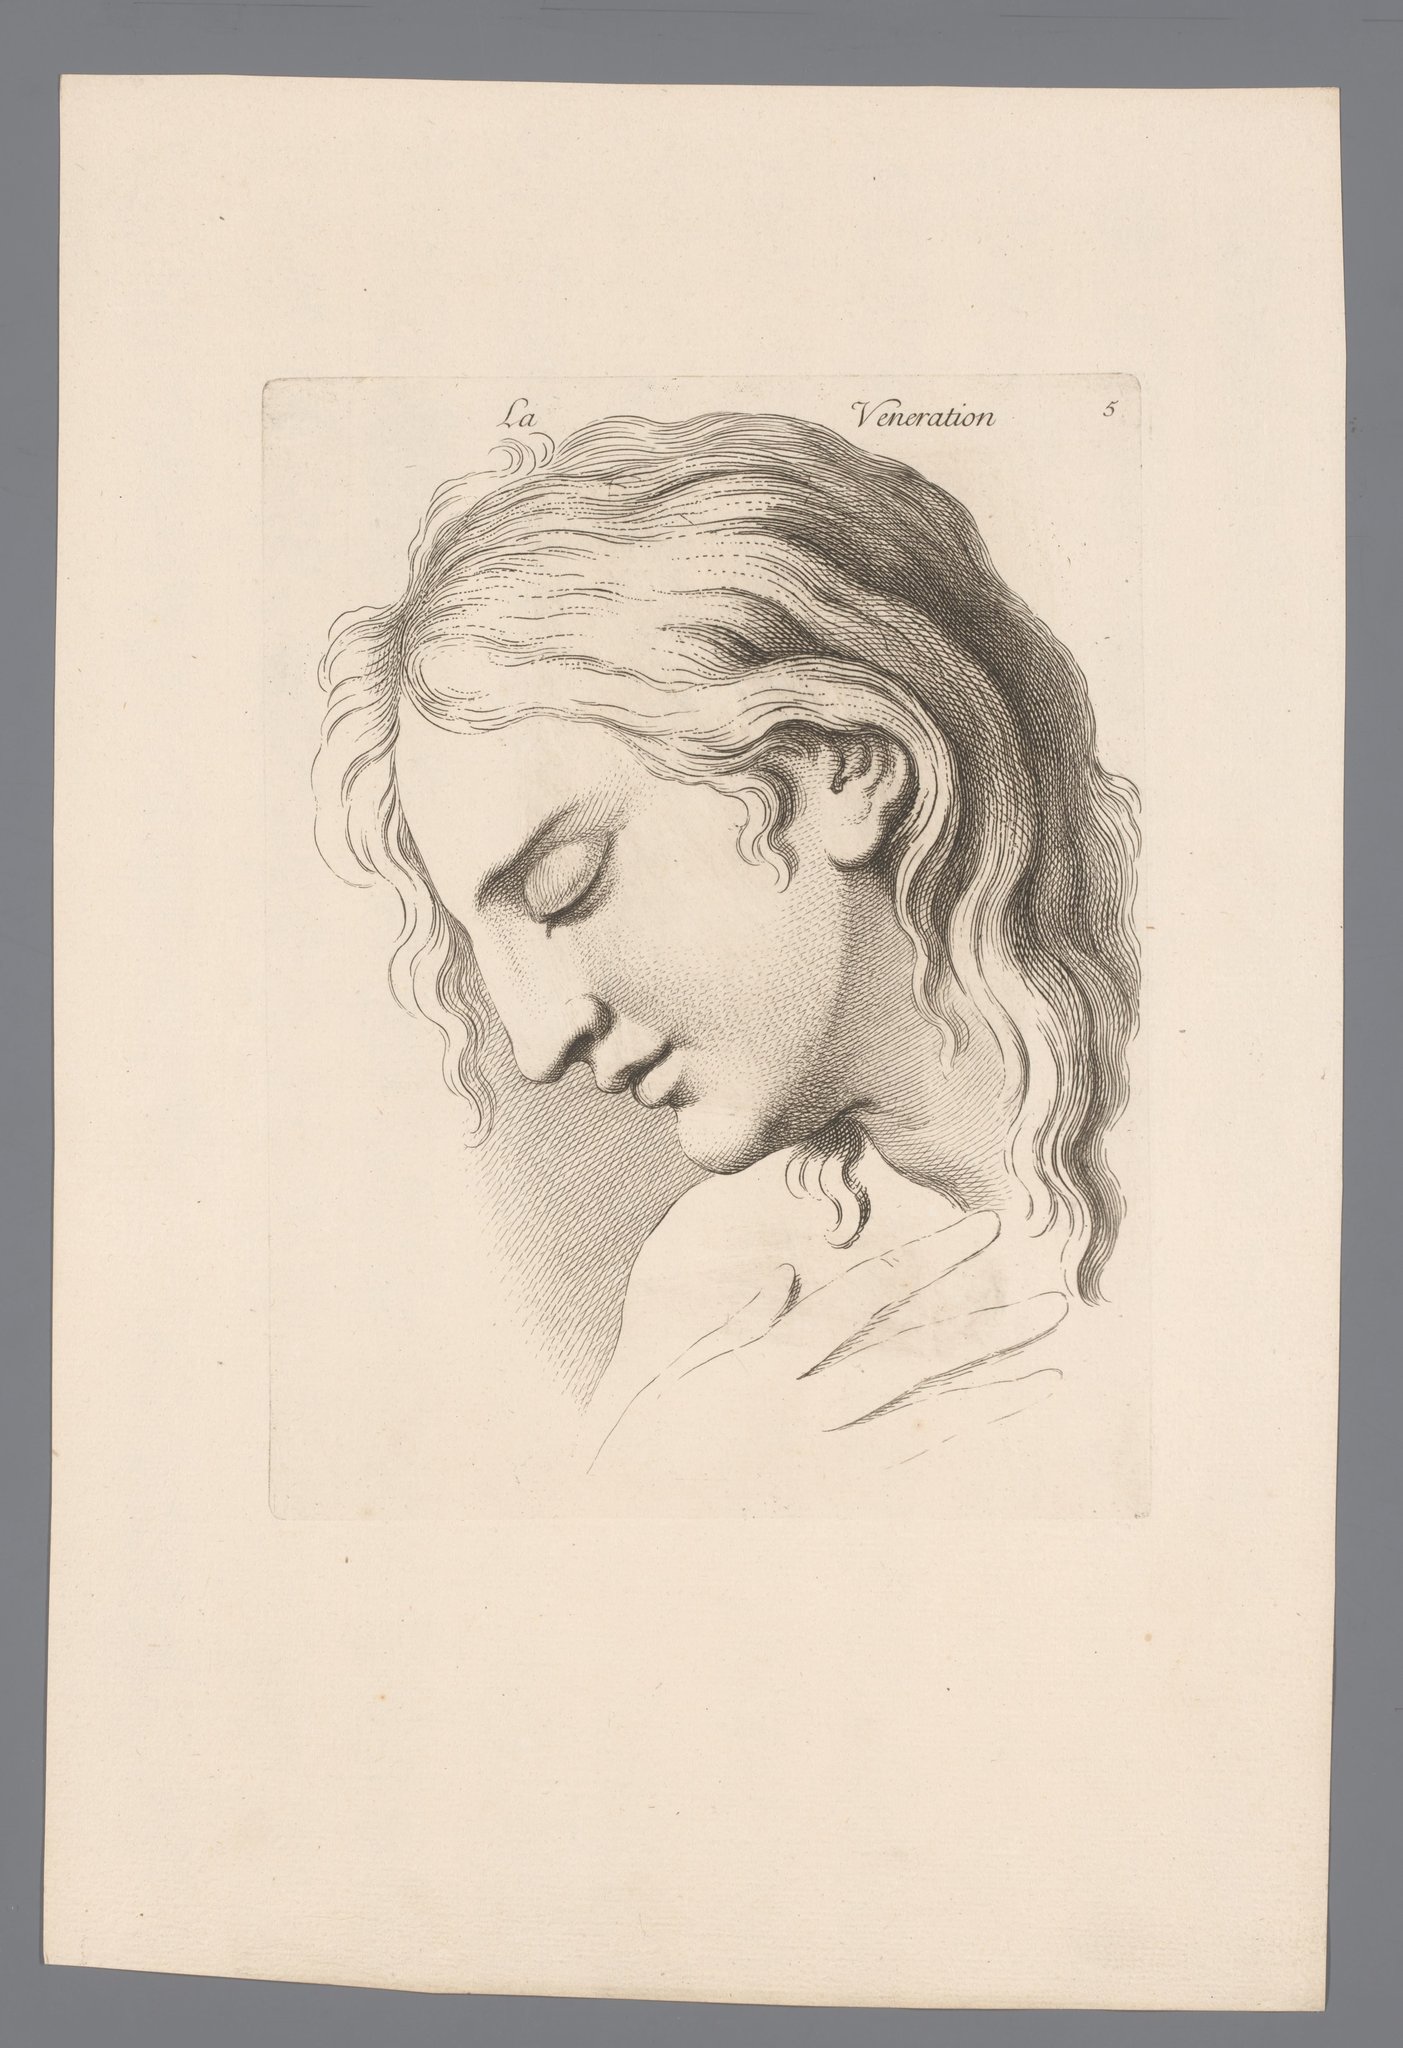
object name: book illustration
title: Verering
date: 1727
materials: paper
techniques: etching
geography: paris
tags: devotion, piety; 'divotione' (ripa), morphology of facial expression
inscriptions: collector's mark: Lugt 2228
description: Prent uit: Le Brun, Charles. Les expressions des passions de l'âme, représentées en plusieurs testes gravées d'après les dessins de feu M. Le Brun. Parijs: Jean Audran, 1727.